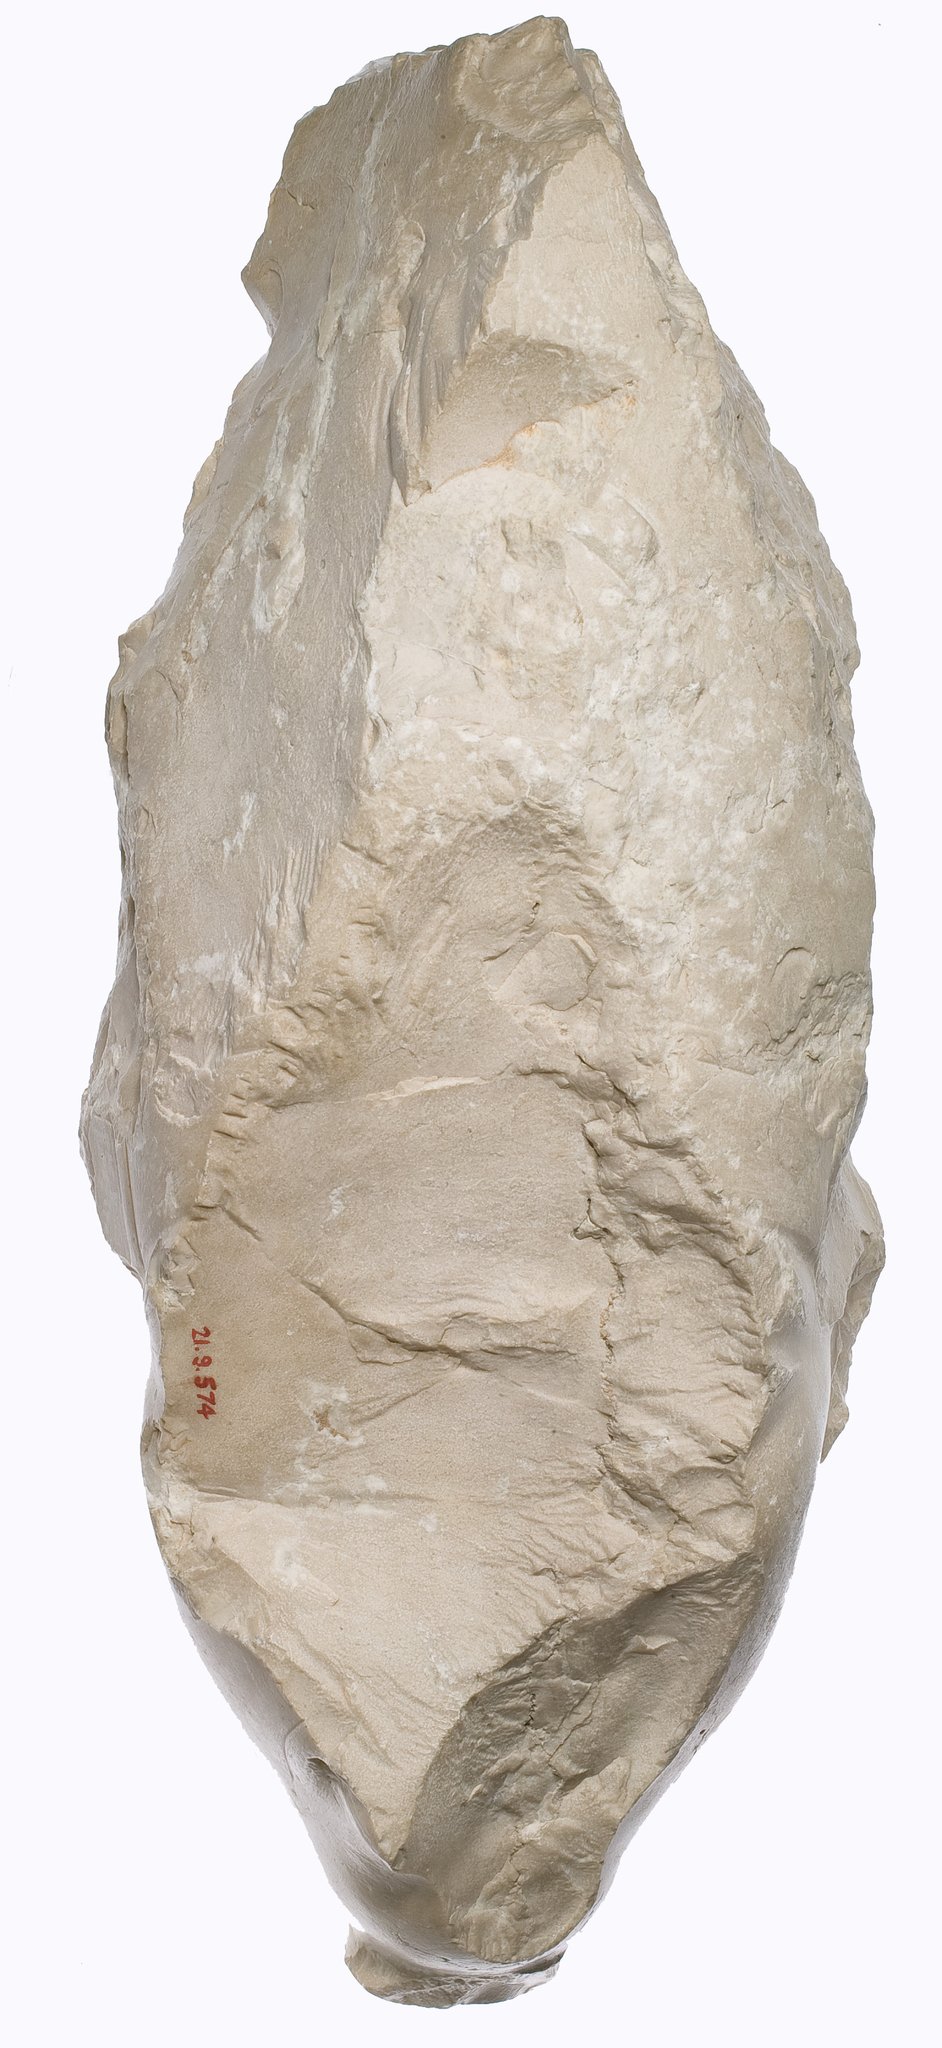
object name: akhenaten, blue crown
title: Akhenaten head, Blue Crown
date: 1353-1336 BCE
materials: limestone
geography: egypt